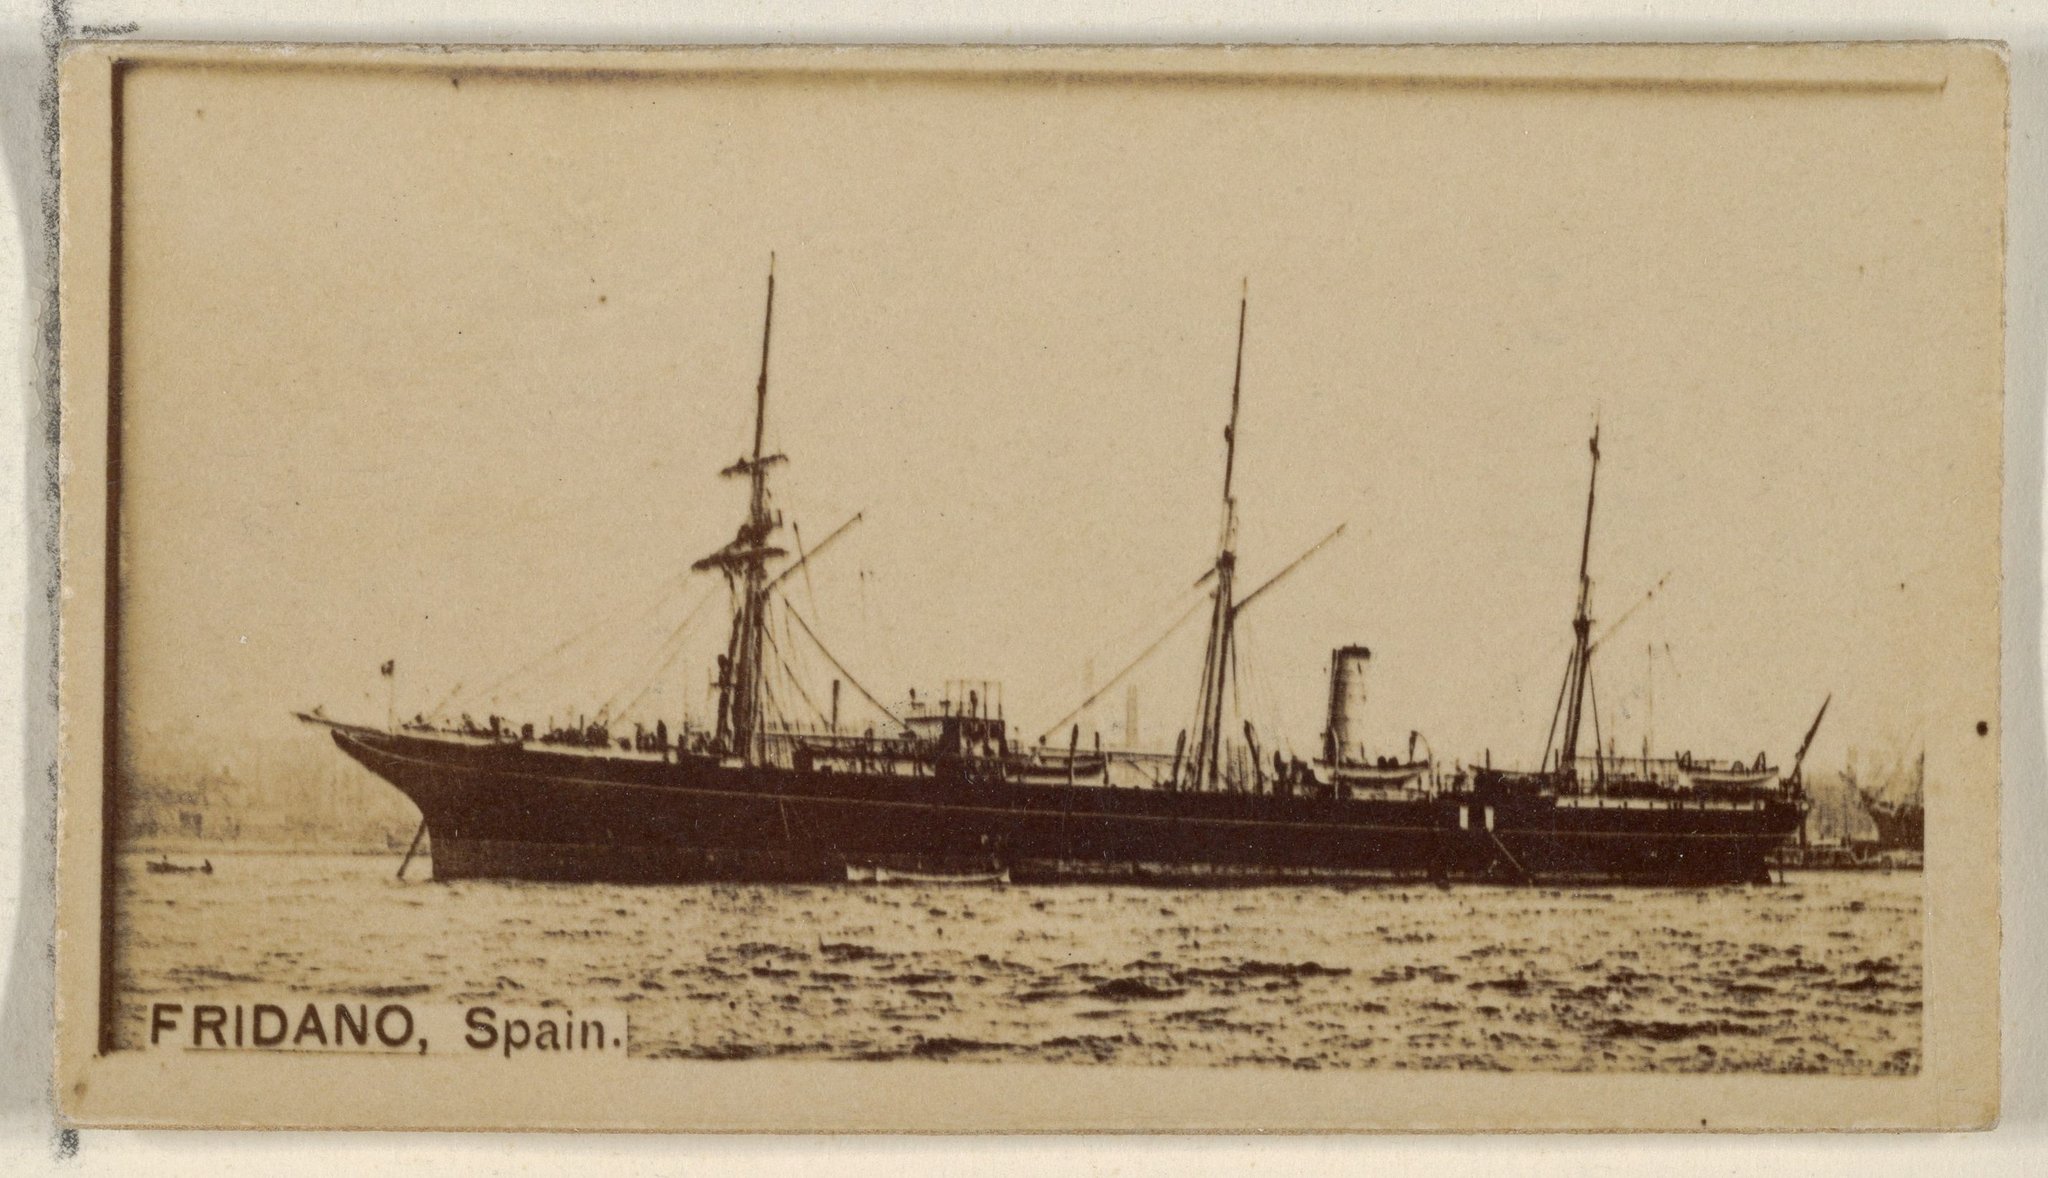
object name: photograph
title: Fridano, Spain, from the Famous Ships series (N50) for Virginia Brights Cigarettes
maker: allen & ginter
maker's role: publisher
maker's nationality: american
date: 1895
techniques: albumen silver print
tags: ships